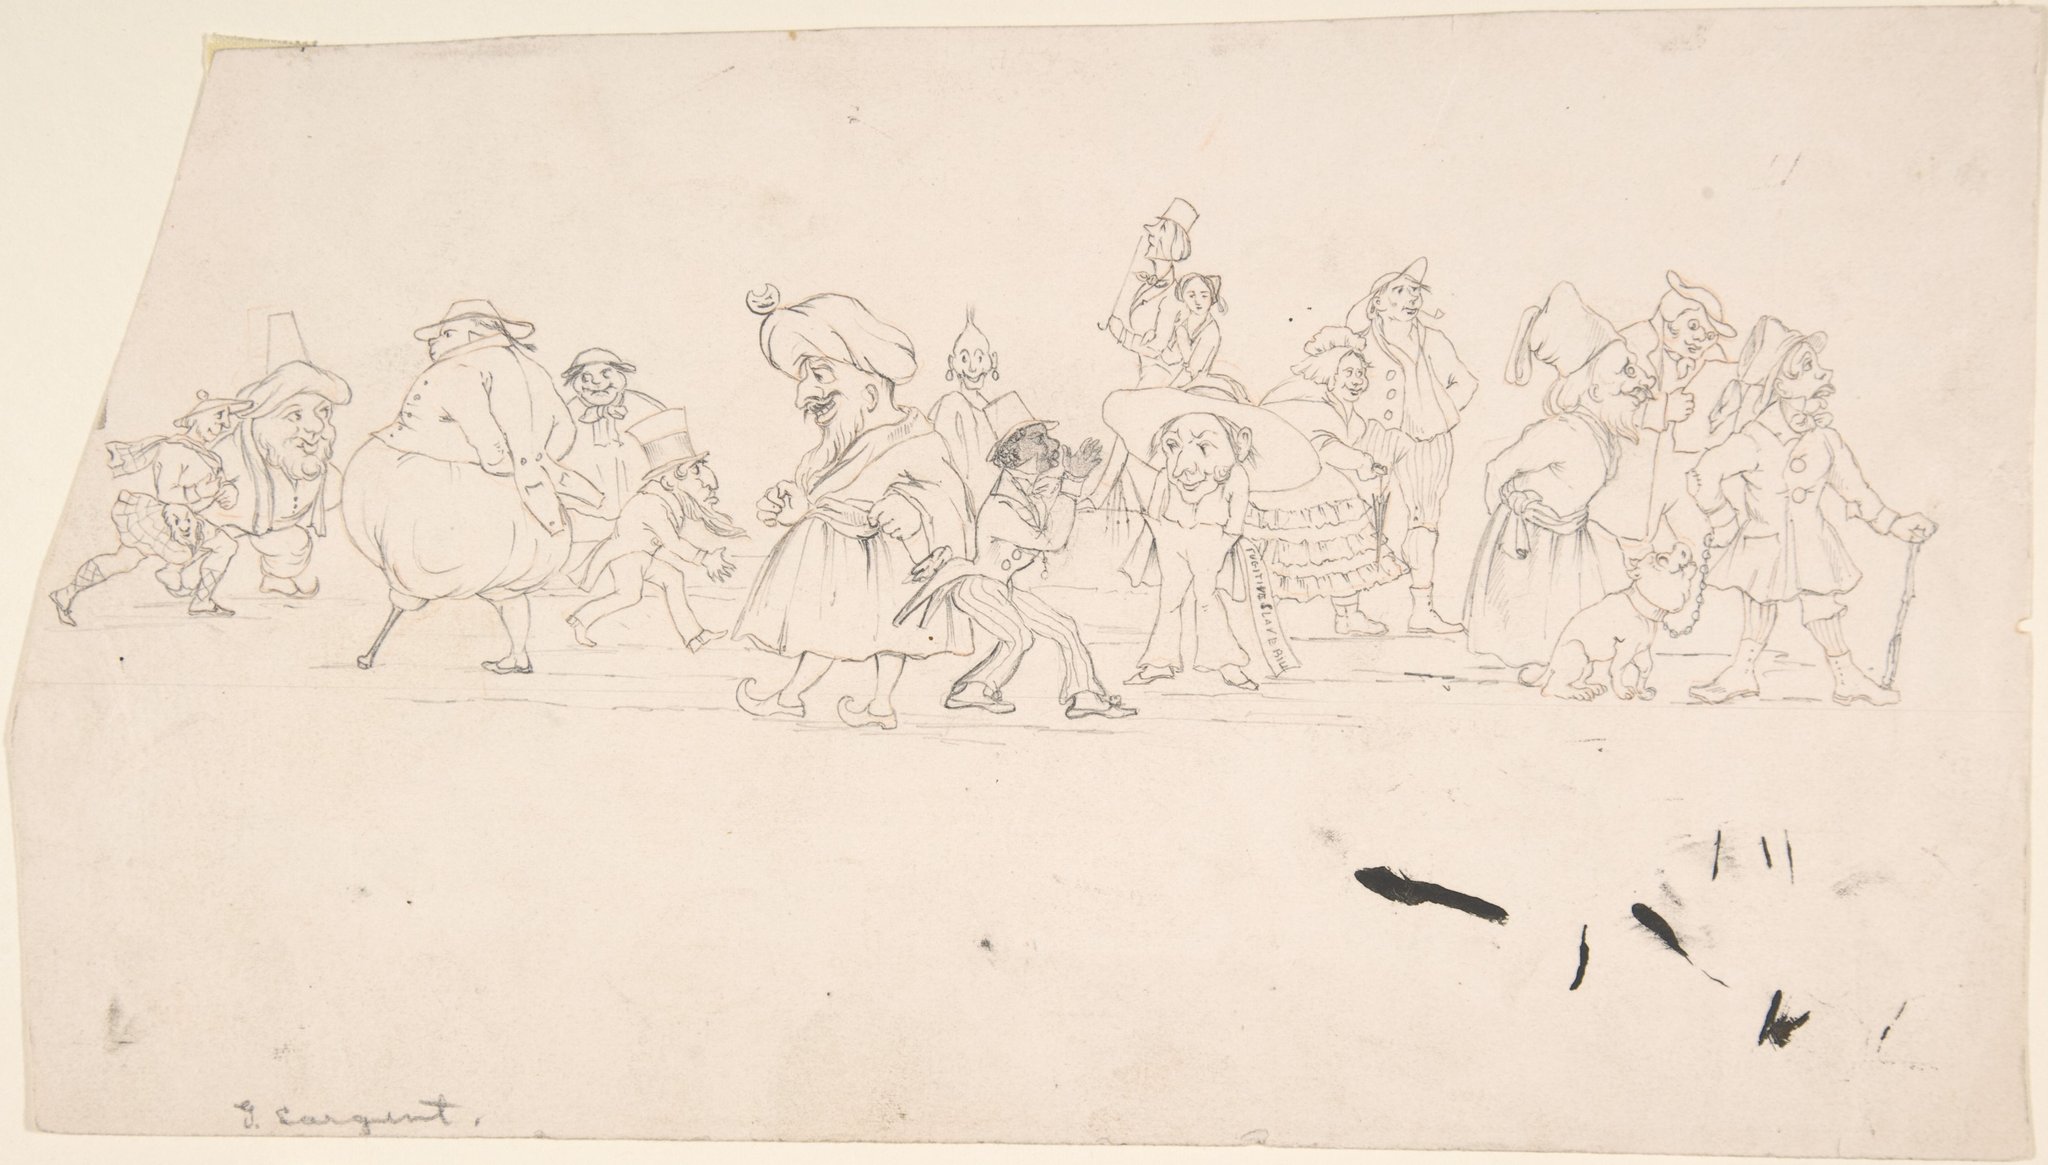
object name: drawing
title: Caricatures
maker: george frederick sargent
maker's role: artist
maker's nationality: british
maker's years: 1811-1864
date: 1850-1860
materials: graphite, ink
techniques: pen